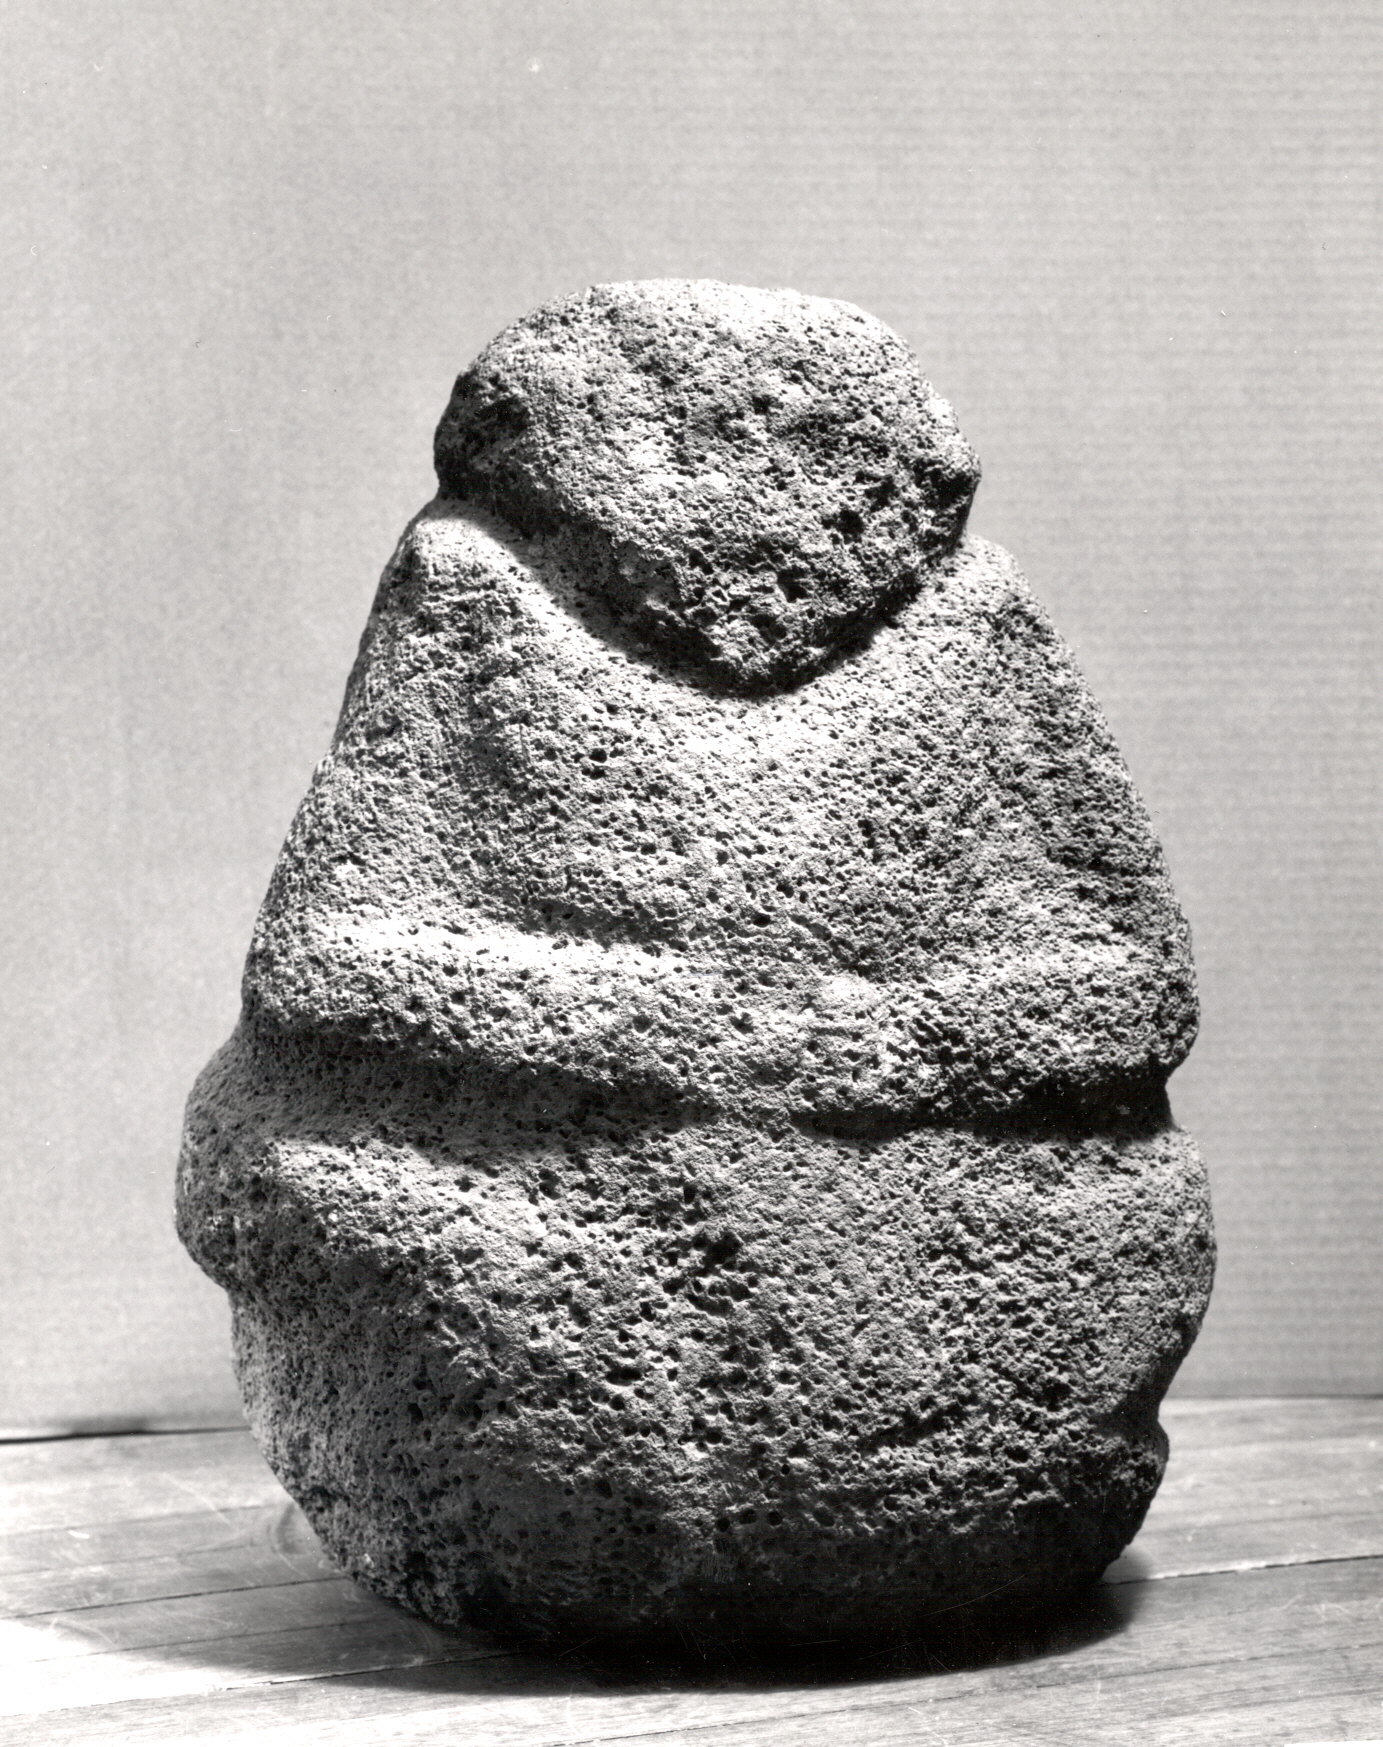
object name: figure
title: Figure ( Ti'i)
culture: maohi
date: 1801-1833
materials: stone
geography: tahiti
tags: human figures